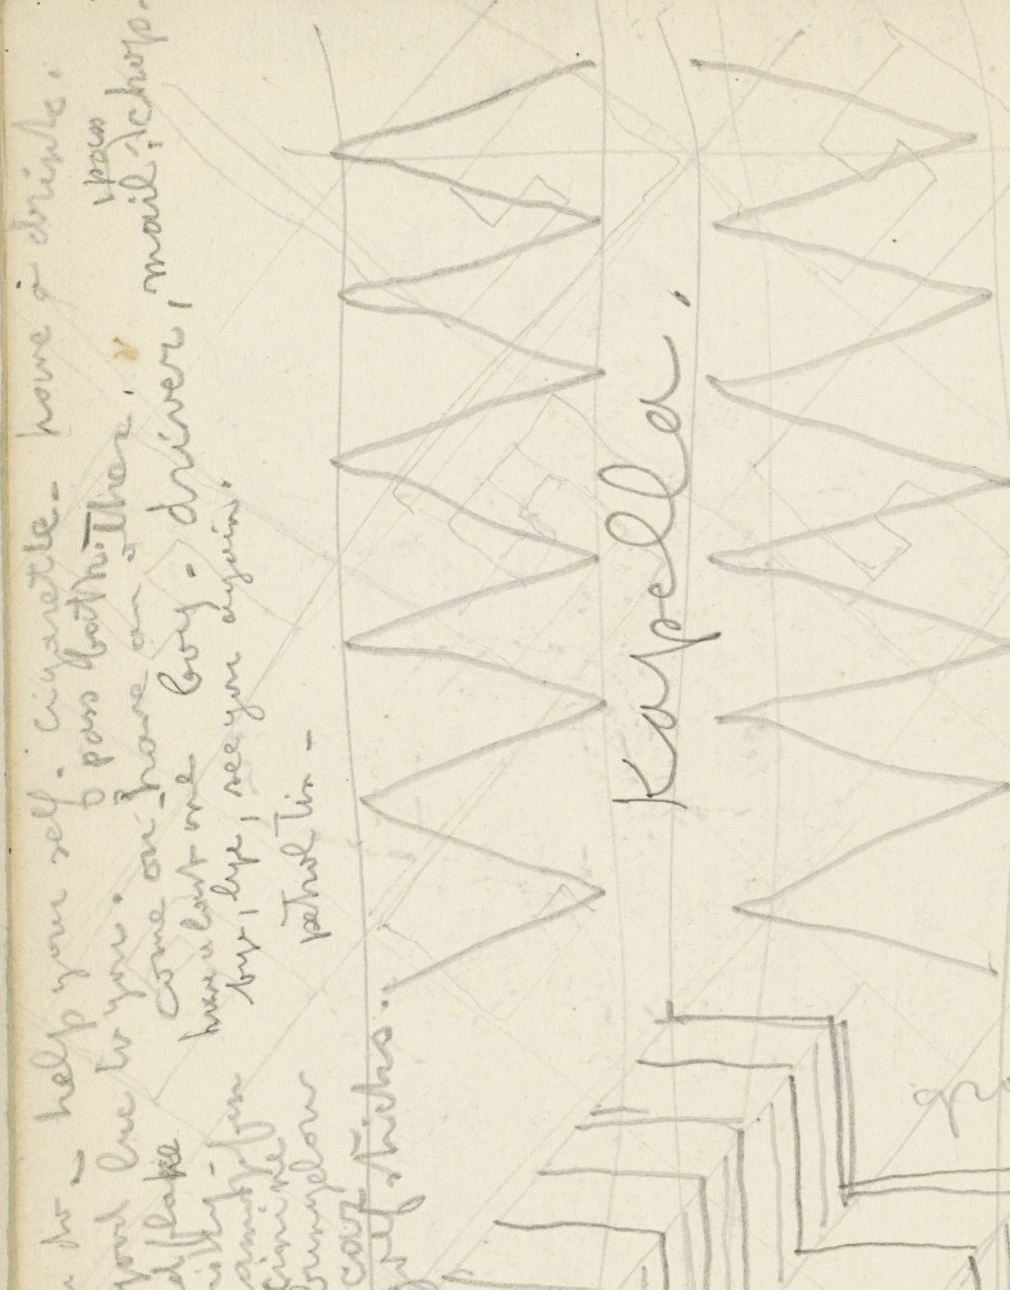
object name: sketchbook leaf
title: Patronen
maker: reijer stolk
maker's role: draughtsman, print maker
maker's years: 1896-1945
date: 1916-1945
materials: paper, pencil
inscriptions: annotation: ‘how do you do - help your self - cigarette - have a drink/ [...] Kapella/ ground’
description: Blad 2 verso uit een schetsboek met 60 bladen.